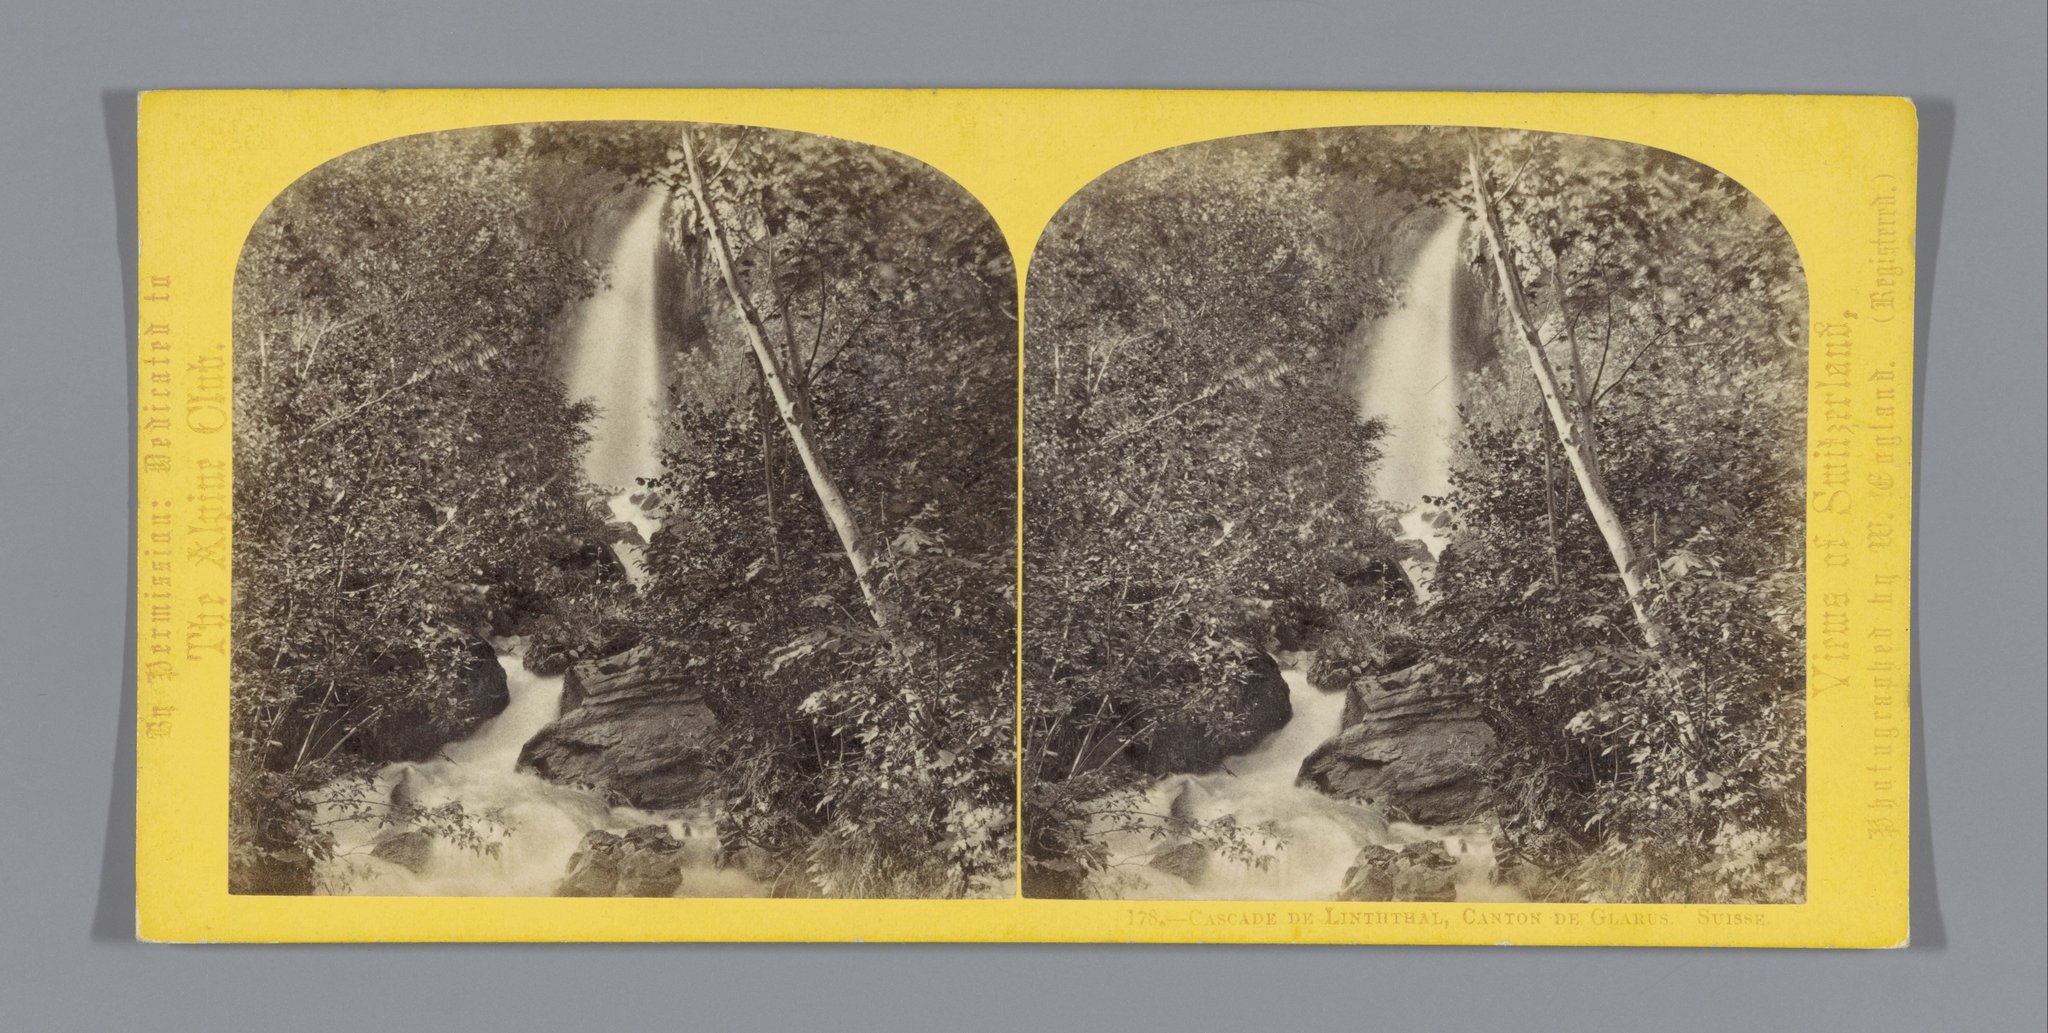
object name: stereograph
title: Gezicht op een waterval in de Linthvallei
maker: william england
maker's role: fotograaf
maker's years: 1816-1896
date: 1850-1880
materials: cardboard, photographic support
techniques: albumen print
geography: glarus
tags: waterfall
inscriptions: number: ‘178.’, inscription: ‘Views of Switzerland, photographed by W. England. (Registered) Under the Special Patronage of the Alpine Club.’